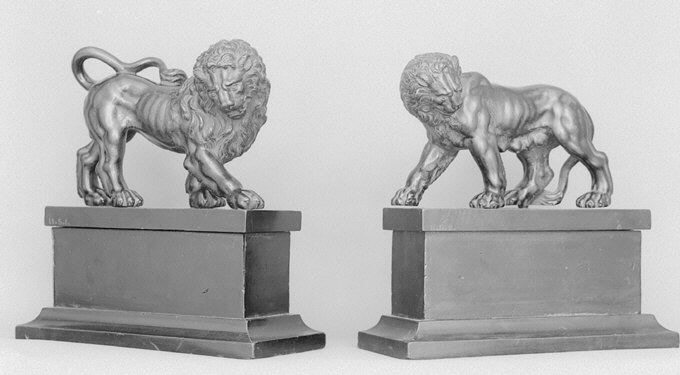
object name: statuette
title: Lion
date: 1701-1900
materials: bronze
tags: lions